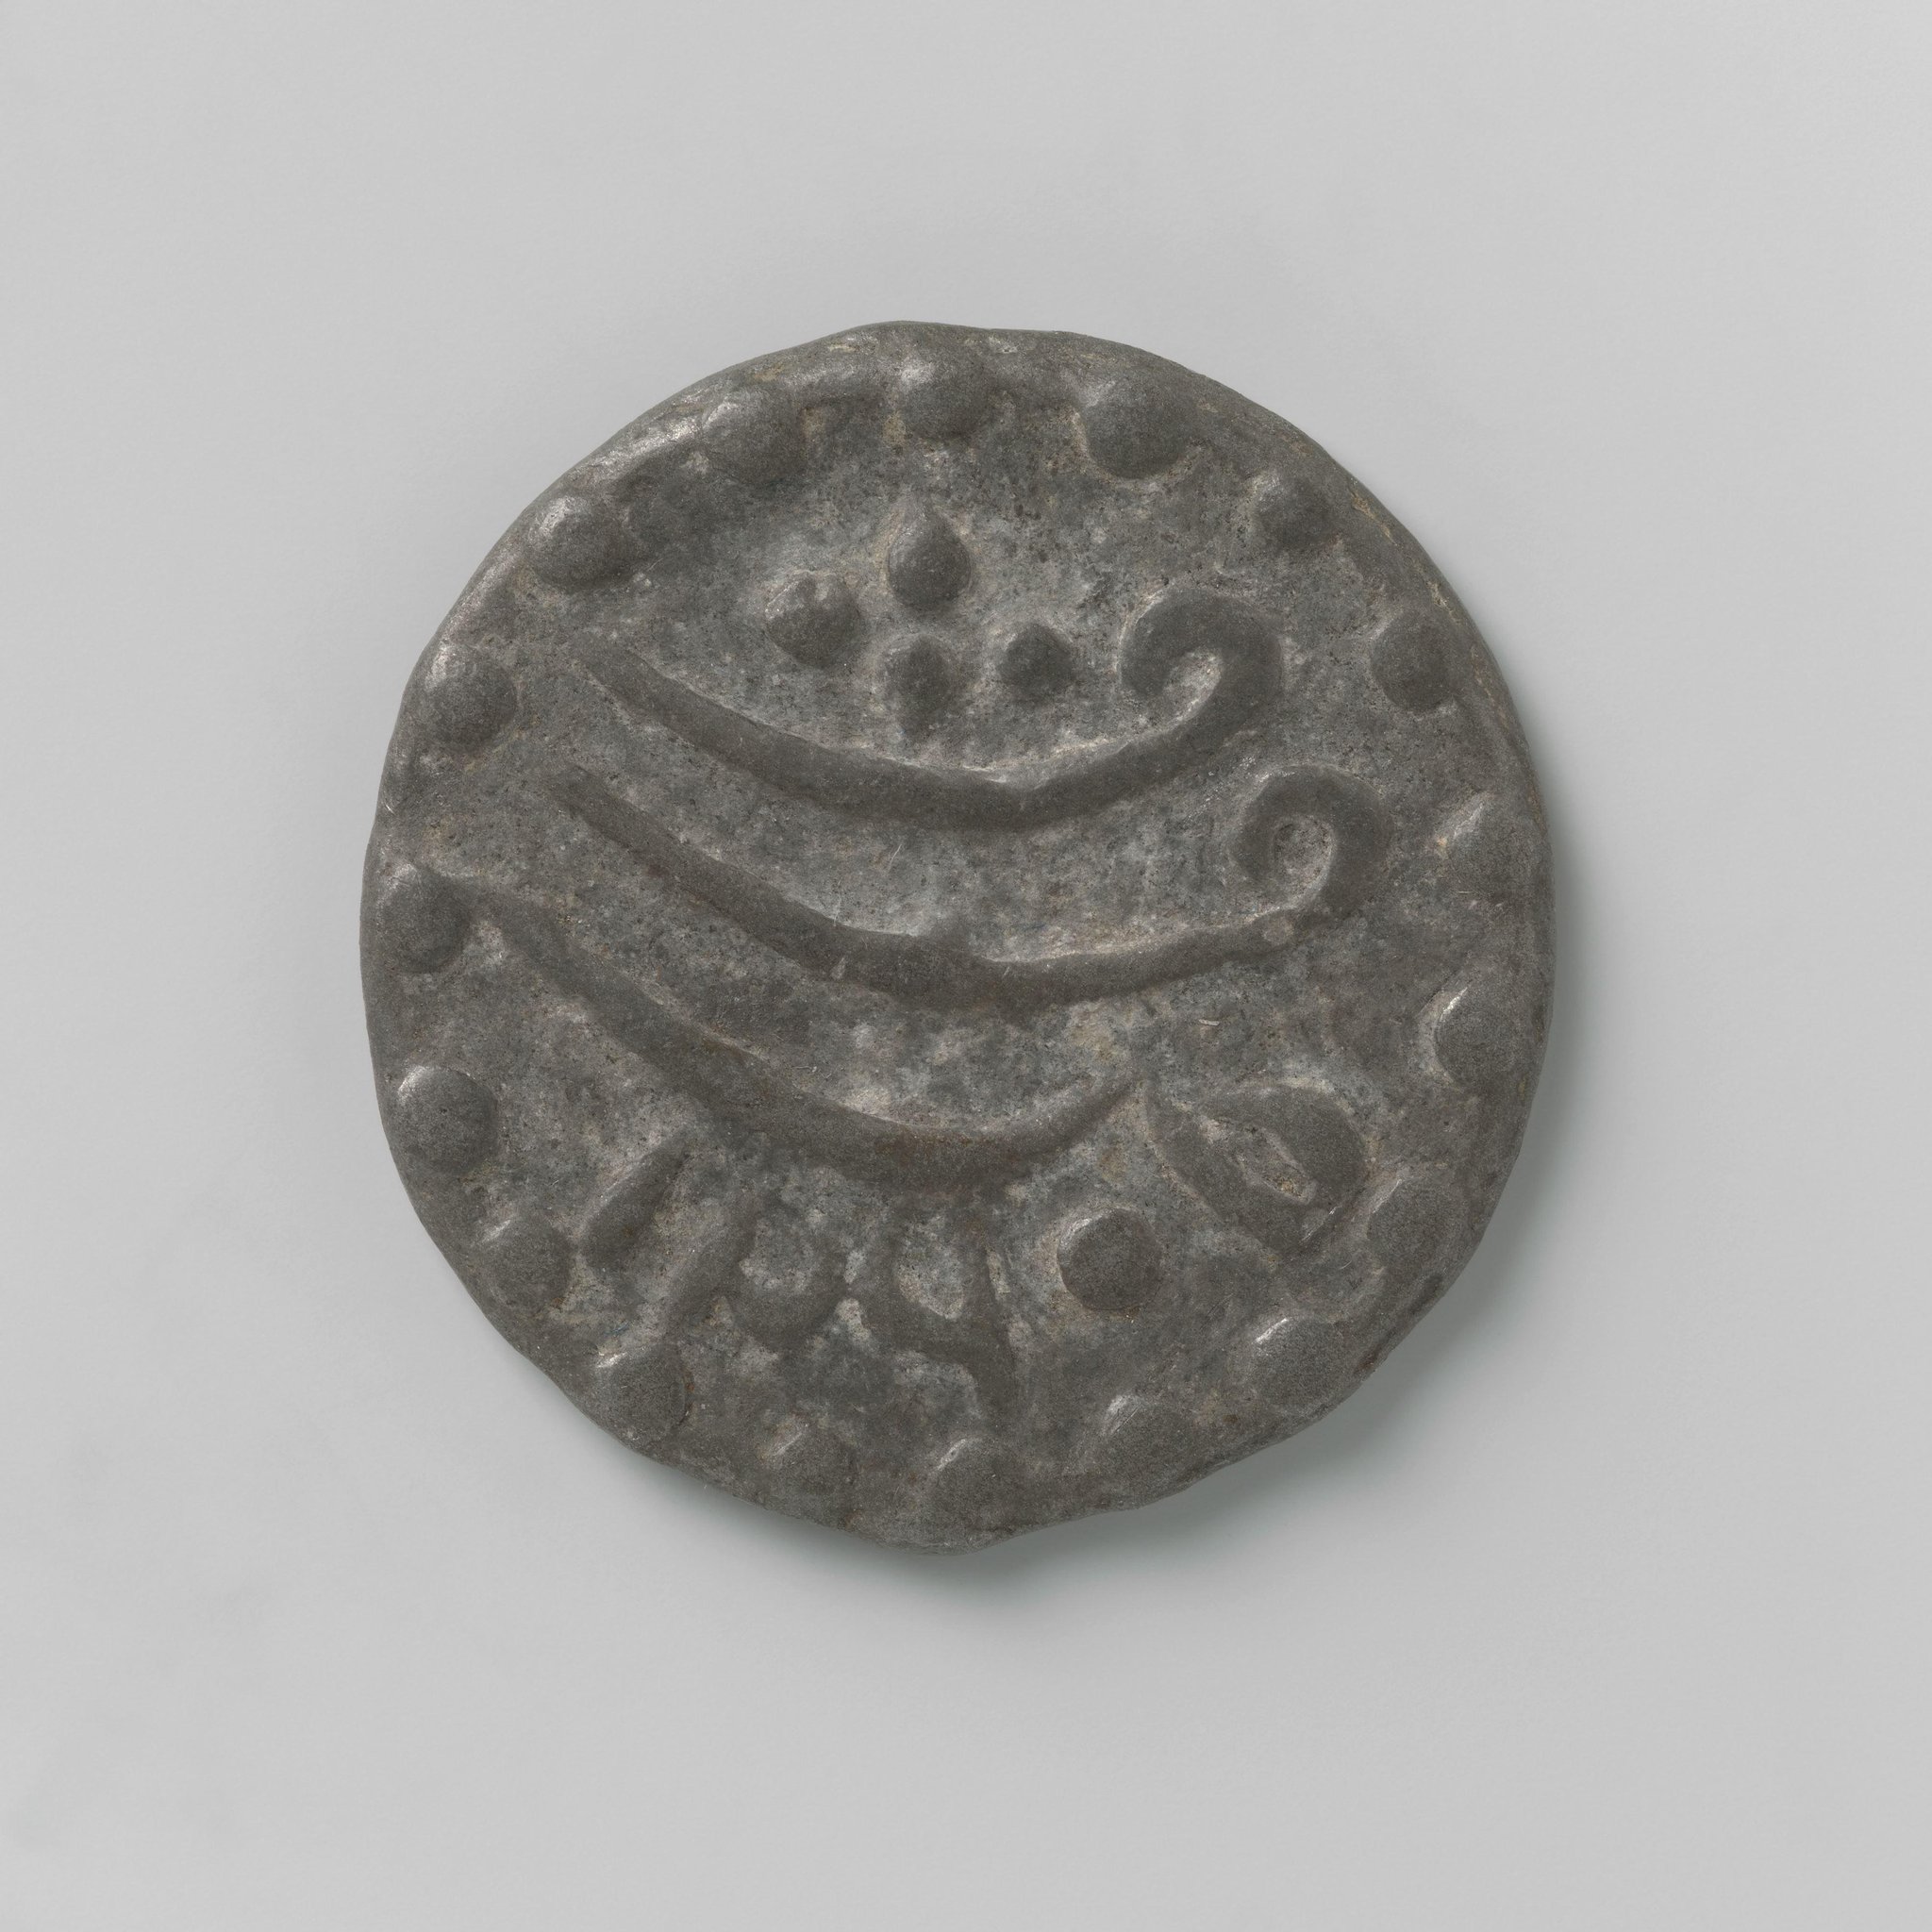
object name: coin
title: Atjeh, Sumatra, sultan Ala ed-din Mansoer II, kasja, AH 1260 (1844)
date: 1844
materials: tin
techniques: casting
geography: aceh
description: Tinnen munt. Voorzijde: drieregelig opschrift in Arabische lettertekens. Keerzijde: drieregelig opschrift in Arabische lettertekens, waaronder jaartal in Islamitische jaartelling